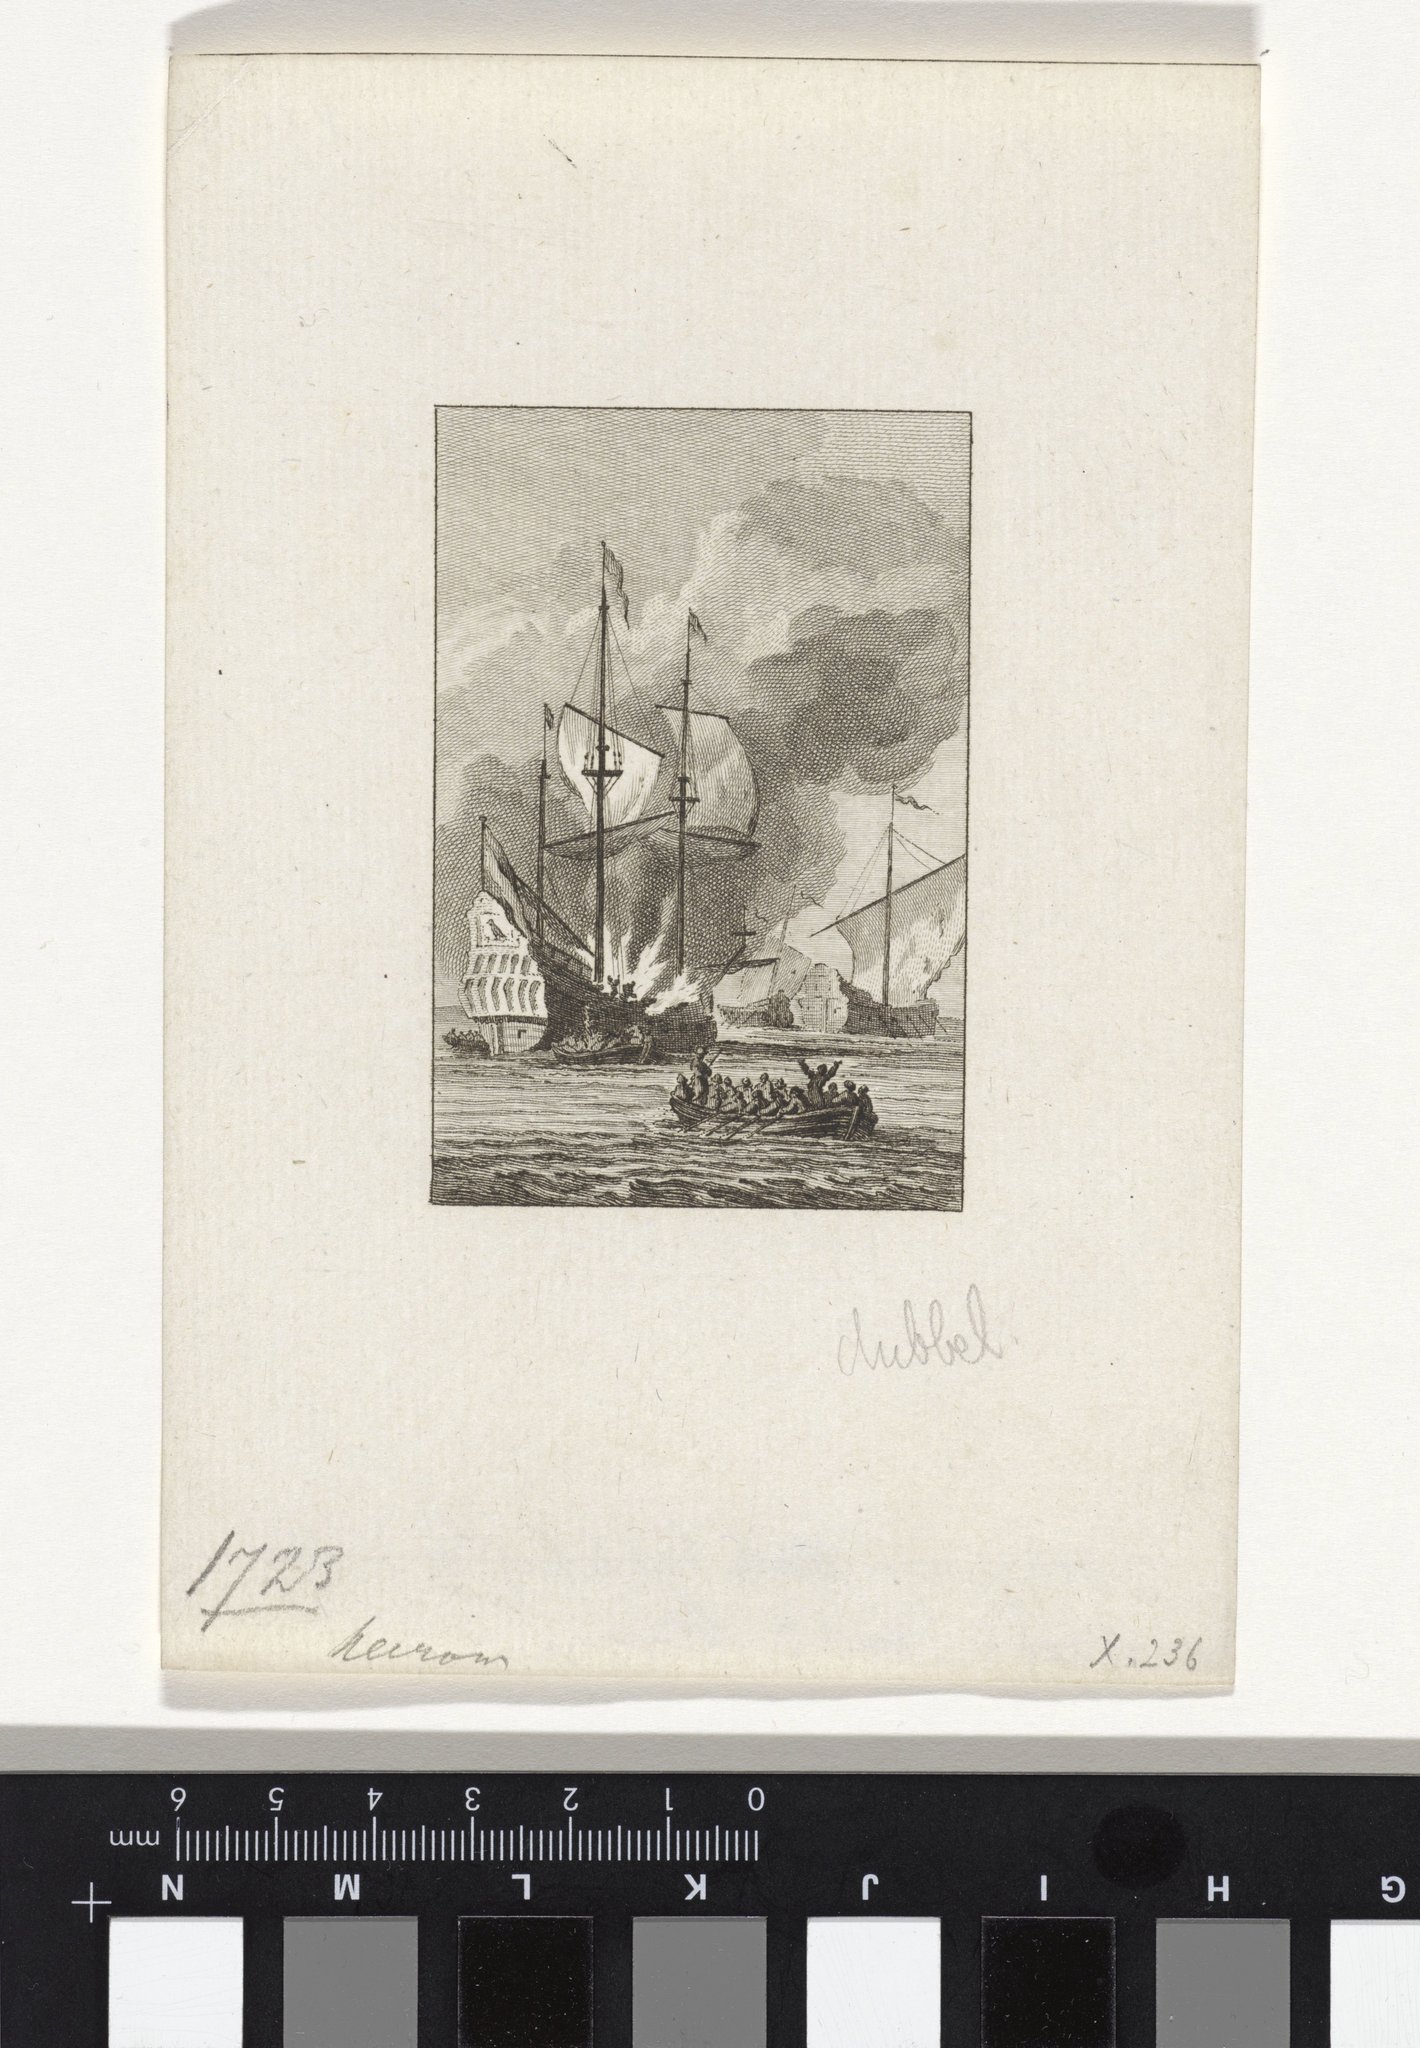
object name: history print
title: Het schip van Pieter Vlak in gevecht met twee Algierse kapers, 1723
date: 1783-1795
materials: paper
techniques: etching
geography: amsterdam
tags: battle (+ naval force), pirate(ship)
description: Illustratie voor: J. Fokke. Geschiedenissen der Vereenigde Nederlanden voor de vaderlandsche jeugd. Amsterdam: Johannes Allart, 1783-1795, 25 delen. deel X pl. I.